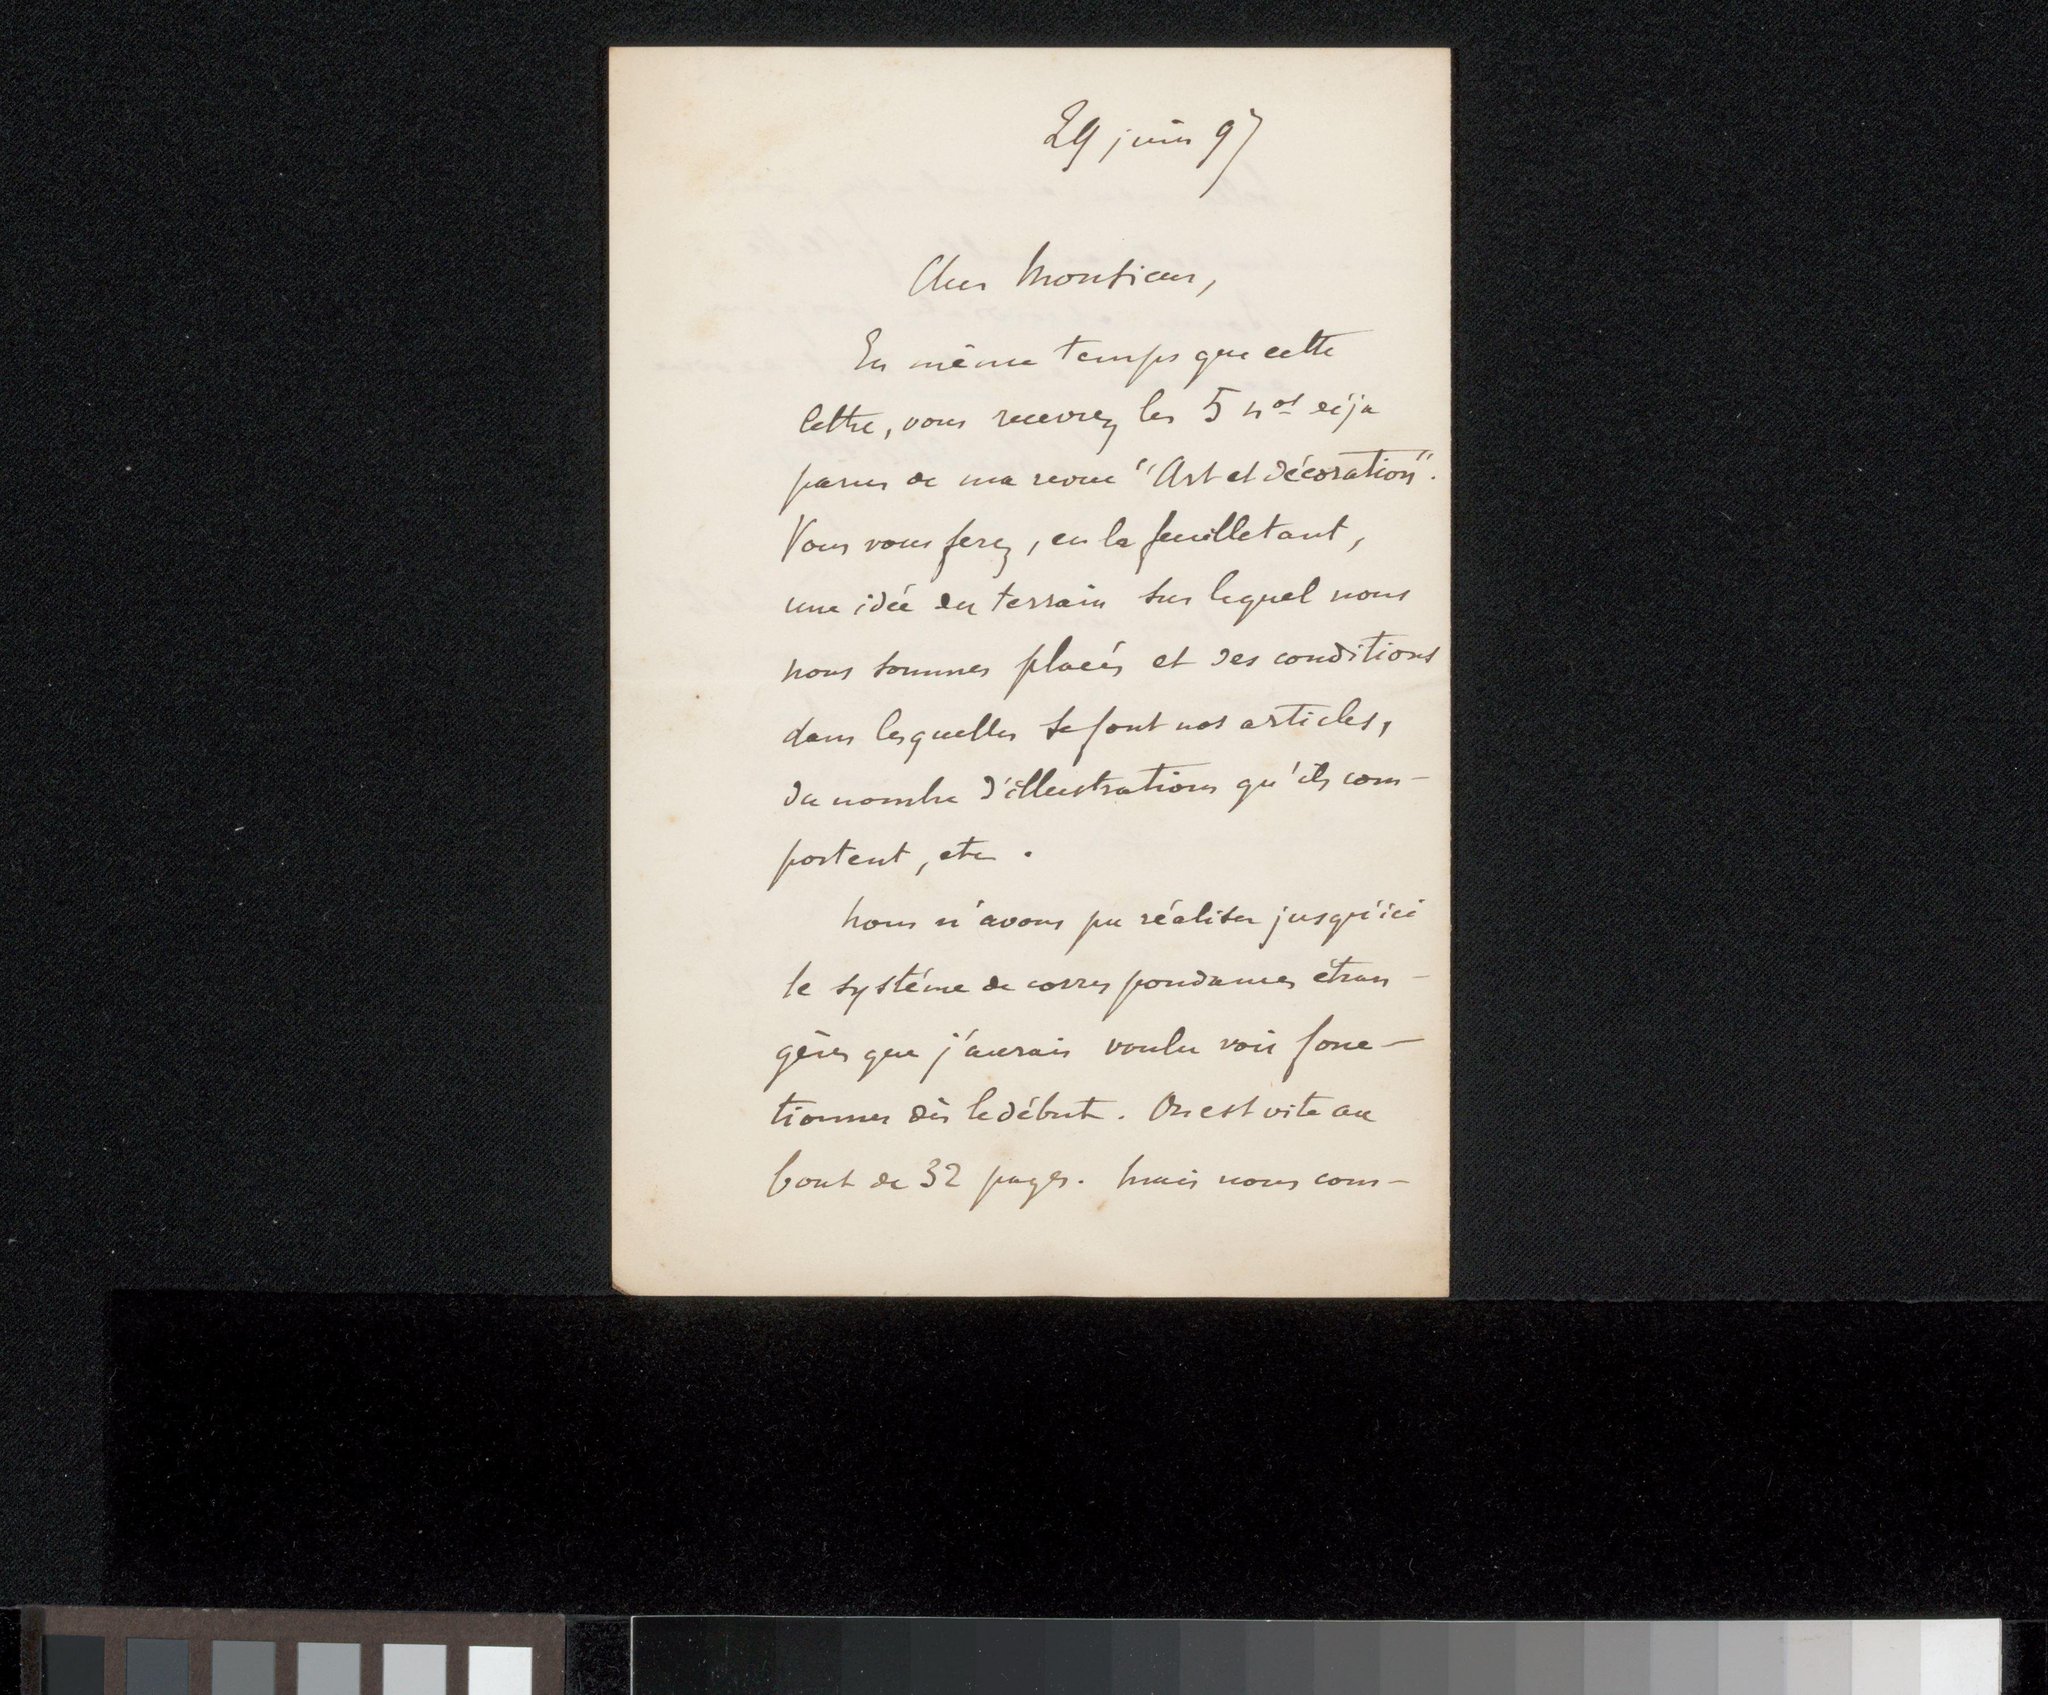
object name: letter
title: Brief aan Philip Zilcken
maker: françois thiébault-sisson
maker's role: kunstcriticus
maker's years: 1856-1944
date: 1897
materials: ink, paper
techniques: pen, writing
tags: the hague, painter, print maker, theo van hoytema, charles snabilié, philip zilcken, illustration ~ printed matter, book, money, printed matter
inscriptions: watermark, collector's mark: ‘RPK’